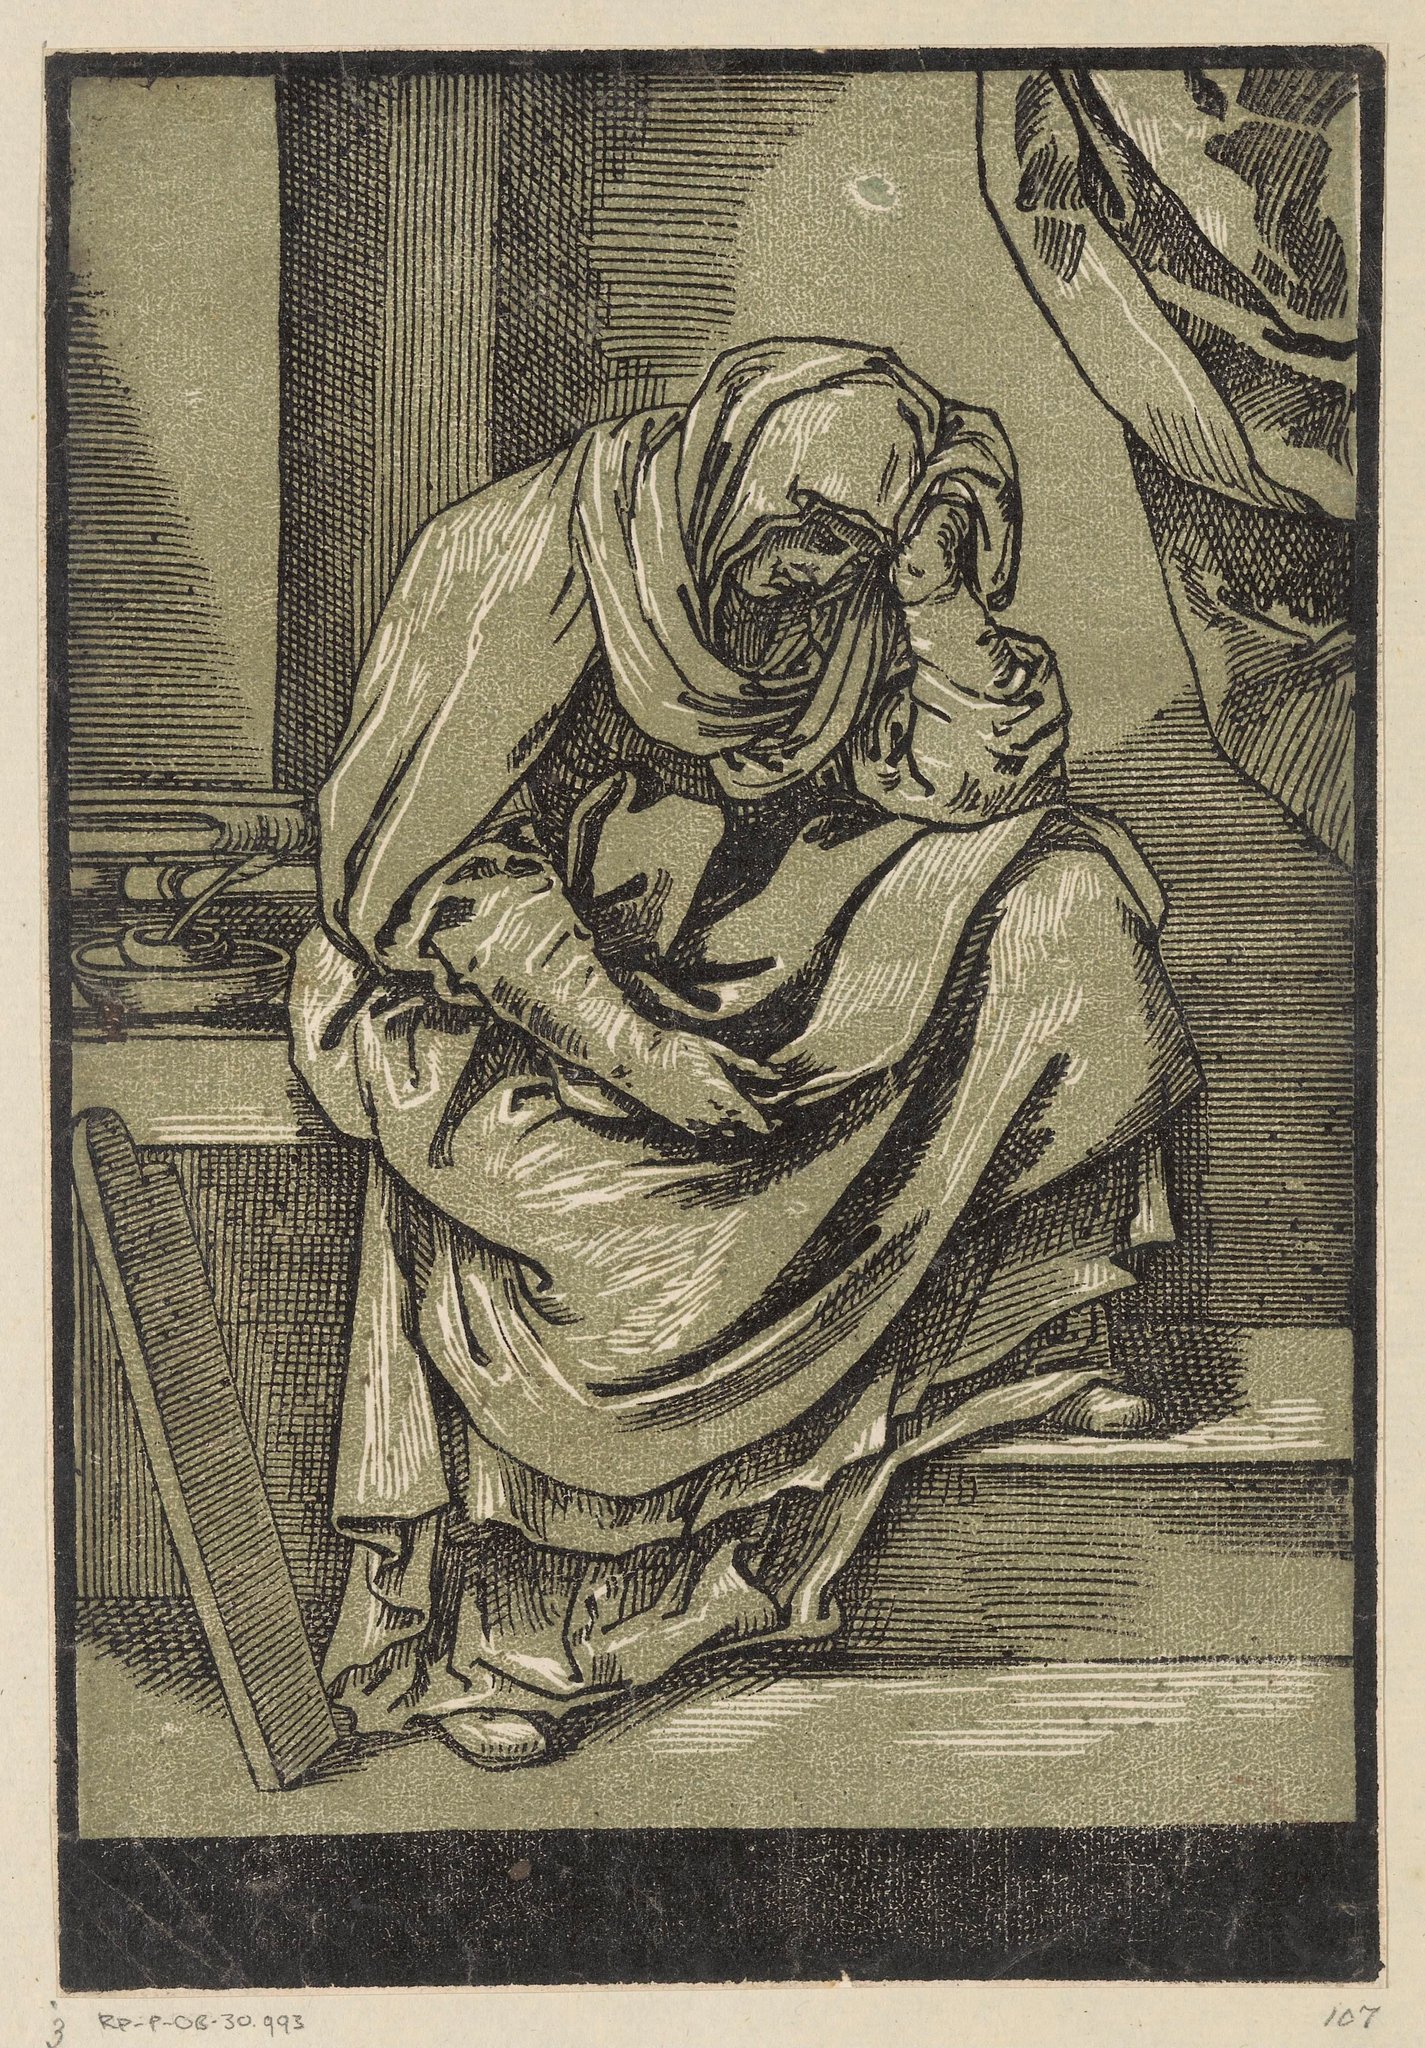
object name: print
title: Sibille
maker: bartolommeo coriolano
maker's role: print maker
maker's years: 1599-1676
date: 1609-1676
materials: paper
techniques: woodcut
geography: italy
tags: sibyls, head held in the hand(s), with elbows leaning on an elevation or on the knees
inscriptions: collector's mark: Lugt 240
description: Een sibille, zittend met het hoofd steunend in haar hand. Naast haar een inktpot met een schrijfveer.